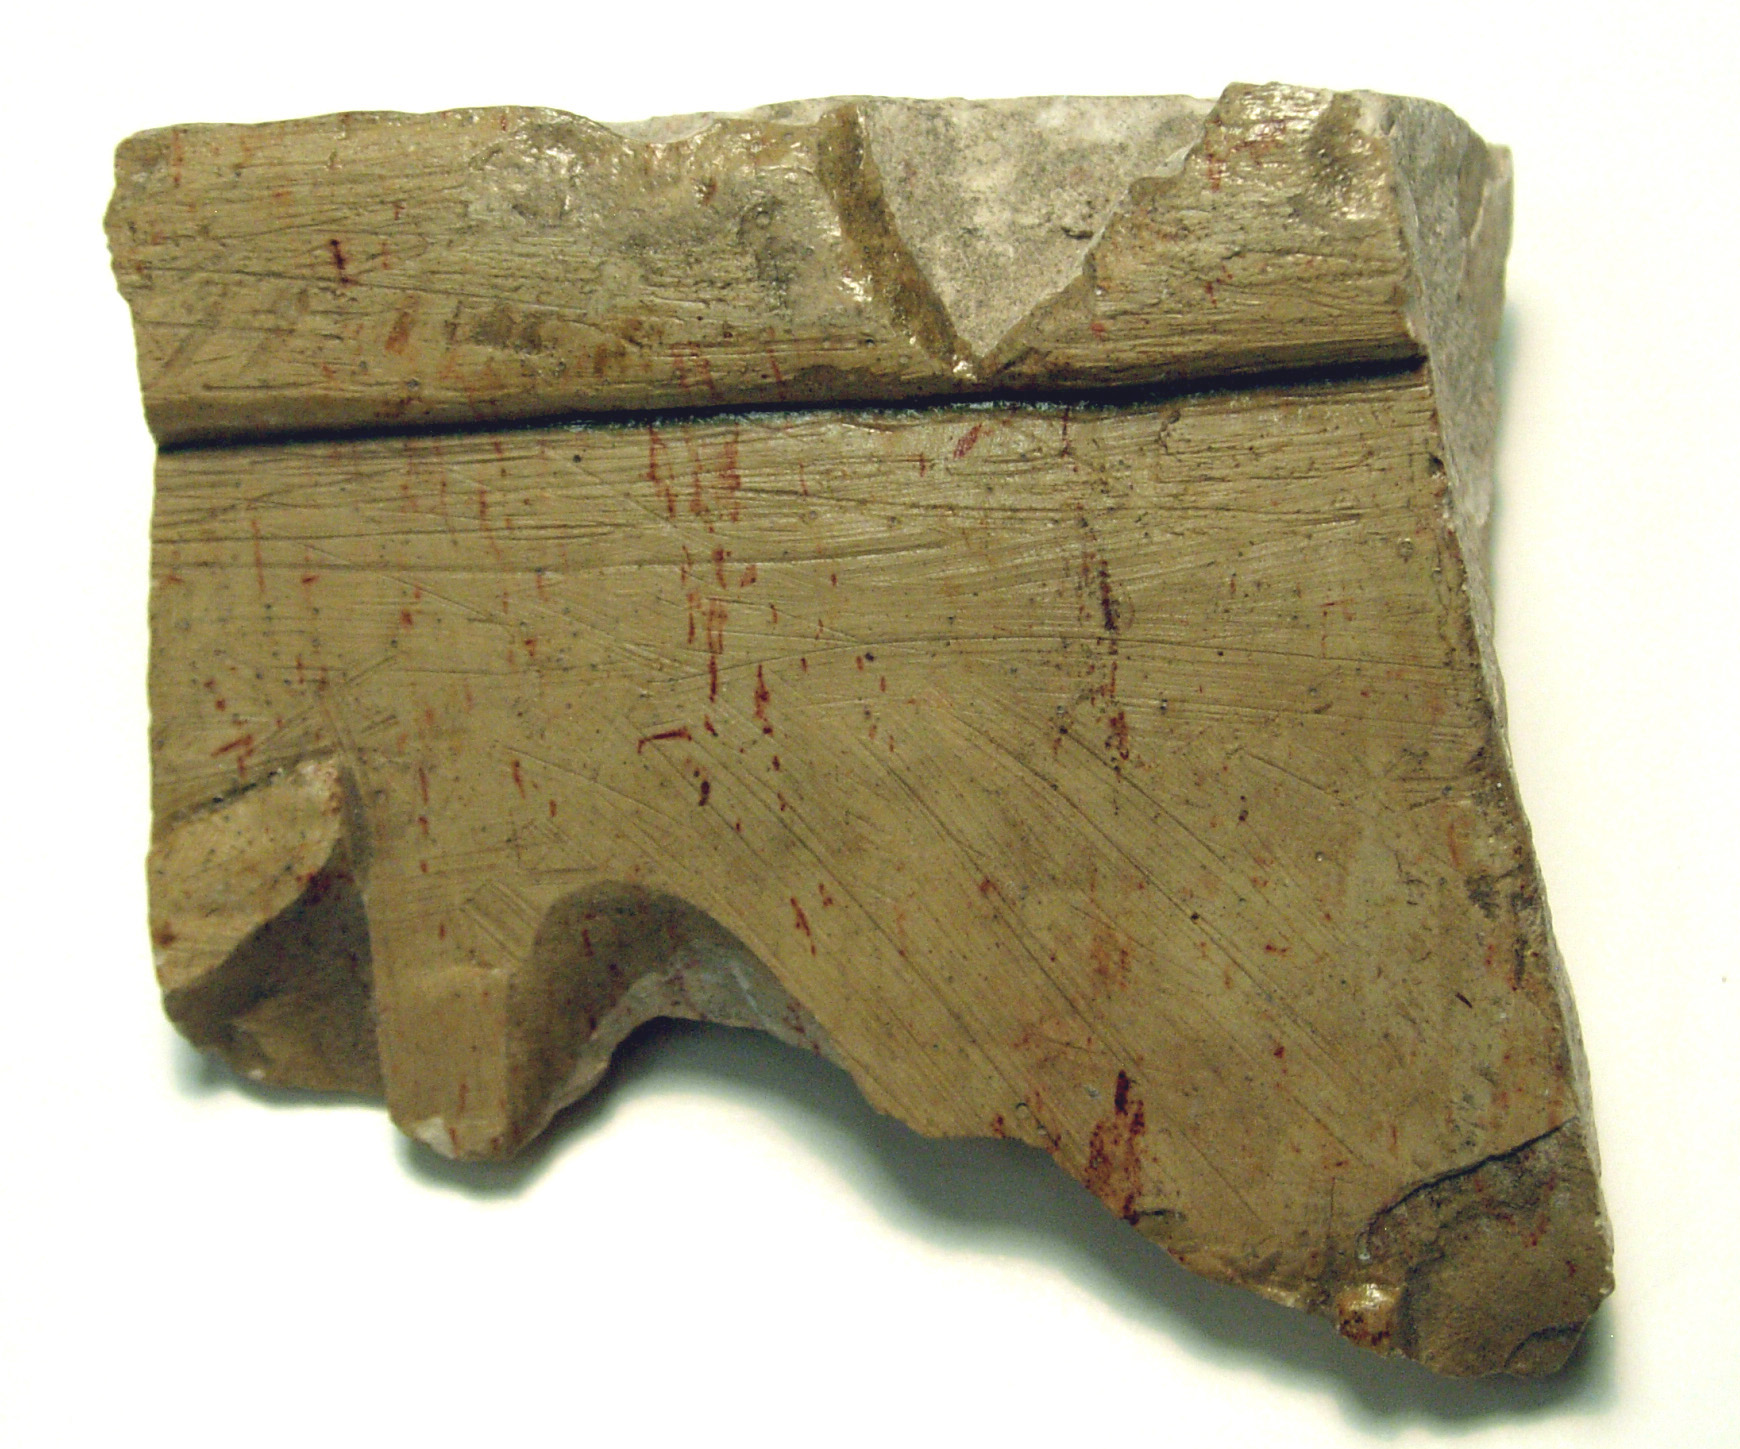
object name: relief, tomb of nespekashuty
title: Raised relief fragment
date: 664-610 BCE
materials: limestone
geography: egypt